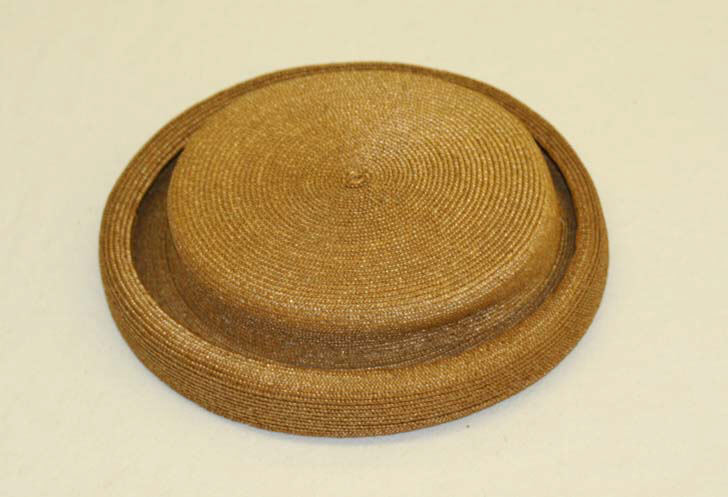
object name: hat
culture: american or european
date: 1860-1870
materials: fiber